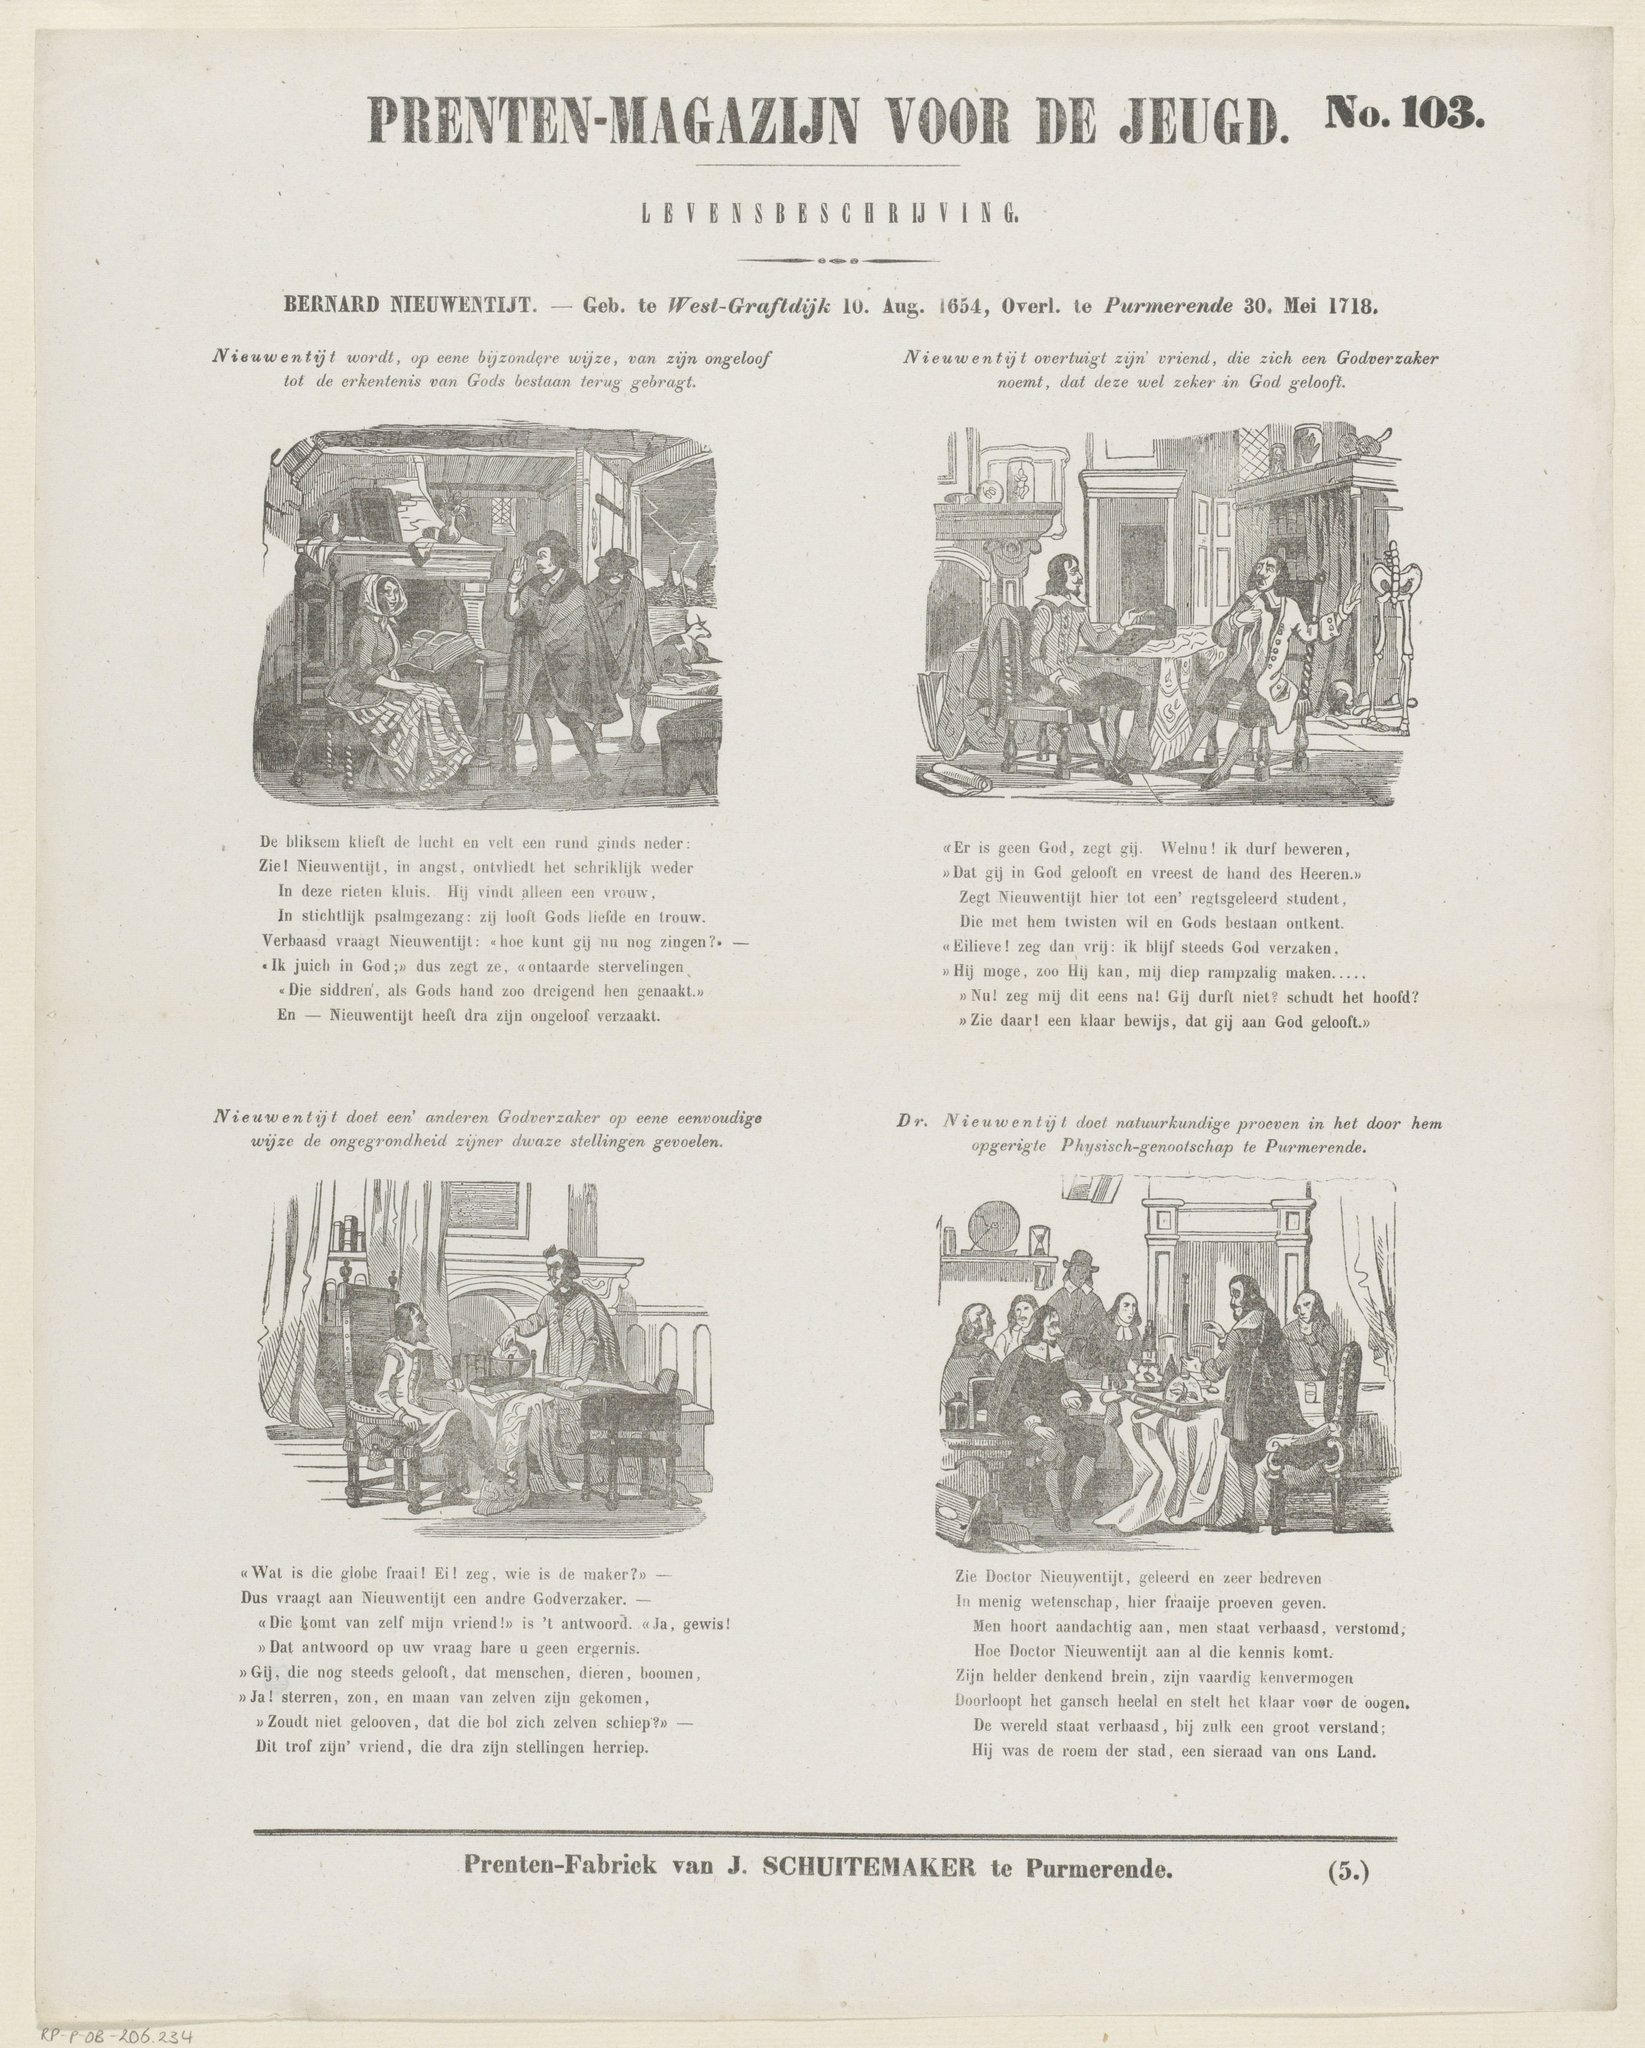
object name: popular print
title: Levensbeschrijving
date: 1850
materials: paper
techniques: letterpress printing, engraving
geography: netherlands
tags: west-graftdijk, wiskundige, arts, bernard nieuwentijt, purmerend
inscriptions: collector's mark: Lugt 2760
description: Na voltooiing van de acht jaargangen van de reeks 'Prenten-magazijn voor de jeugd' in 1850 heeft Jan Schuitemaker al deze prenten heruitgegeven en omgenummerd als nr. 1 t/m 192. De oorspronkelijke jaargang wordt telkens nog vermeld rechtsonder op de prent. Binnen de jaargangen zijn prenten van hetzelfde thema in clusters van vier achter elkaar gezet.